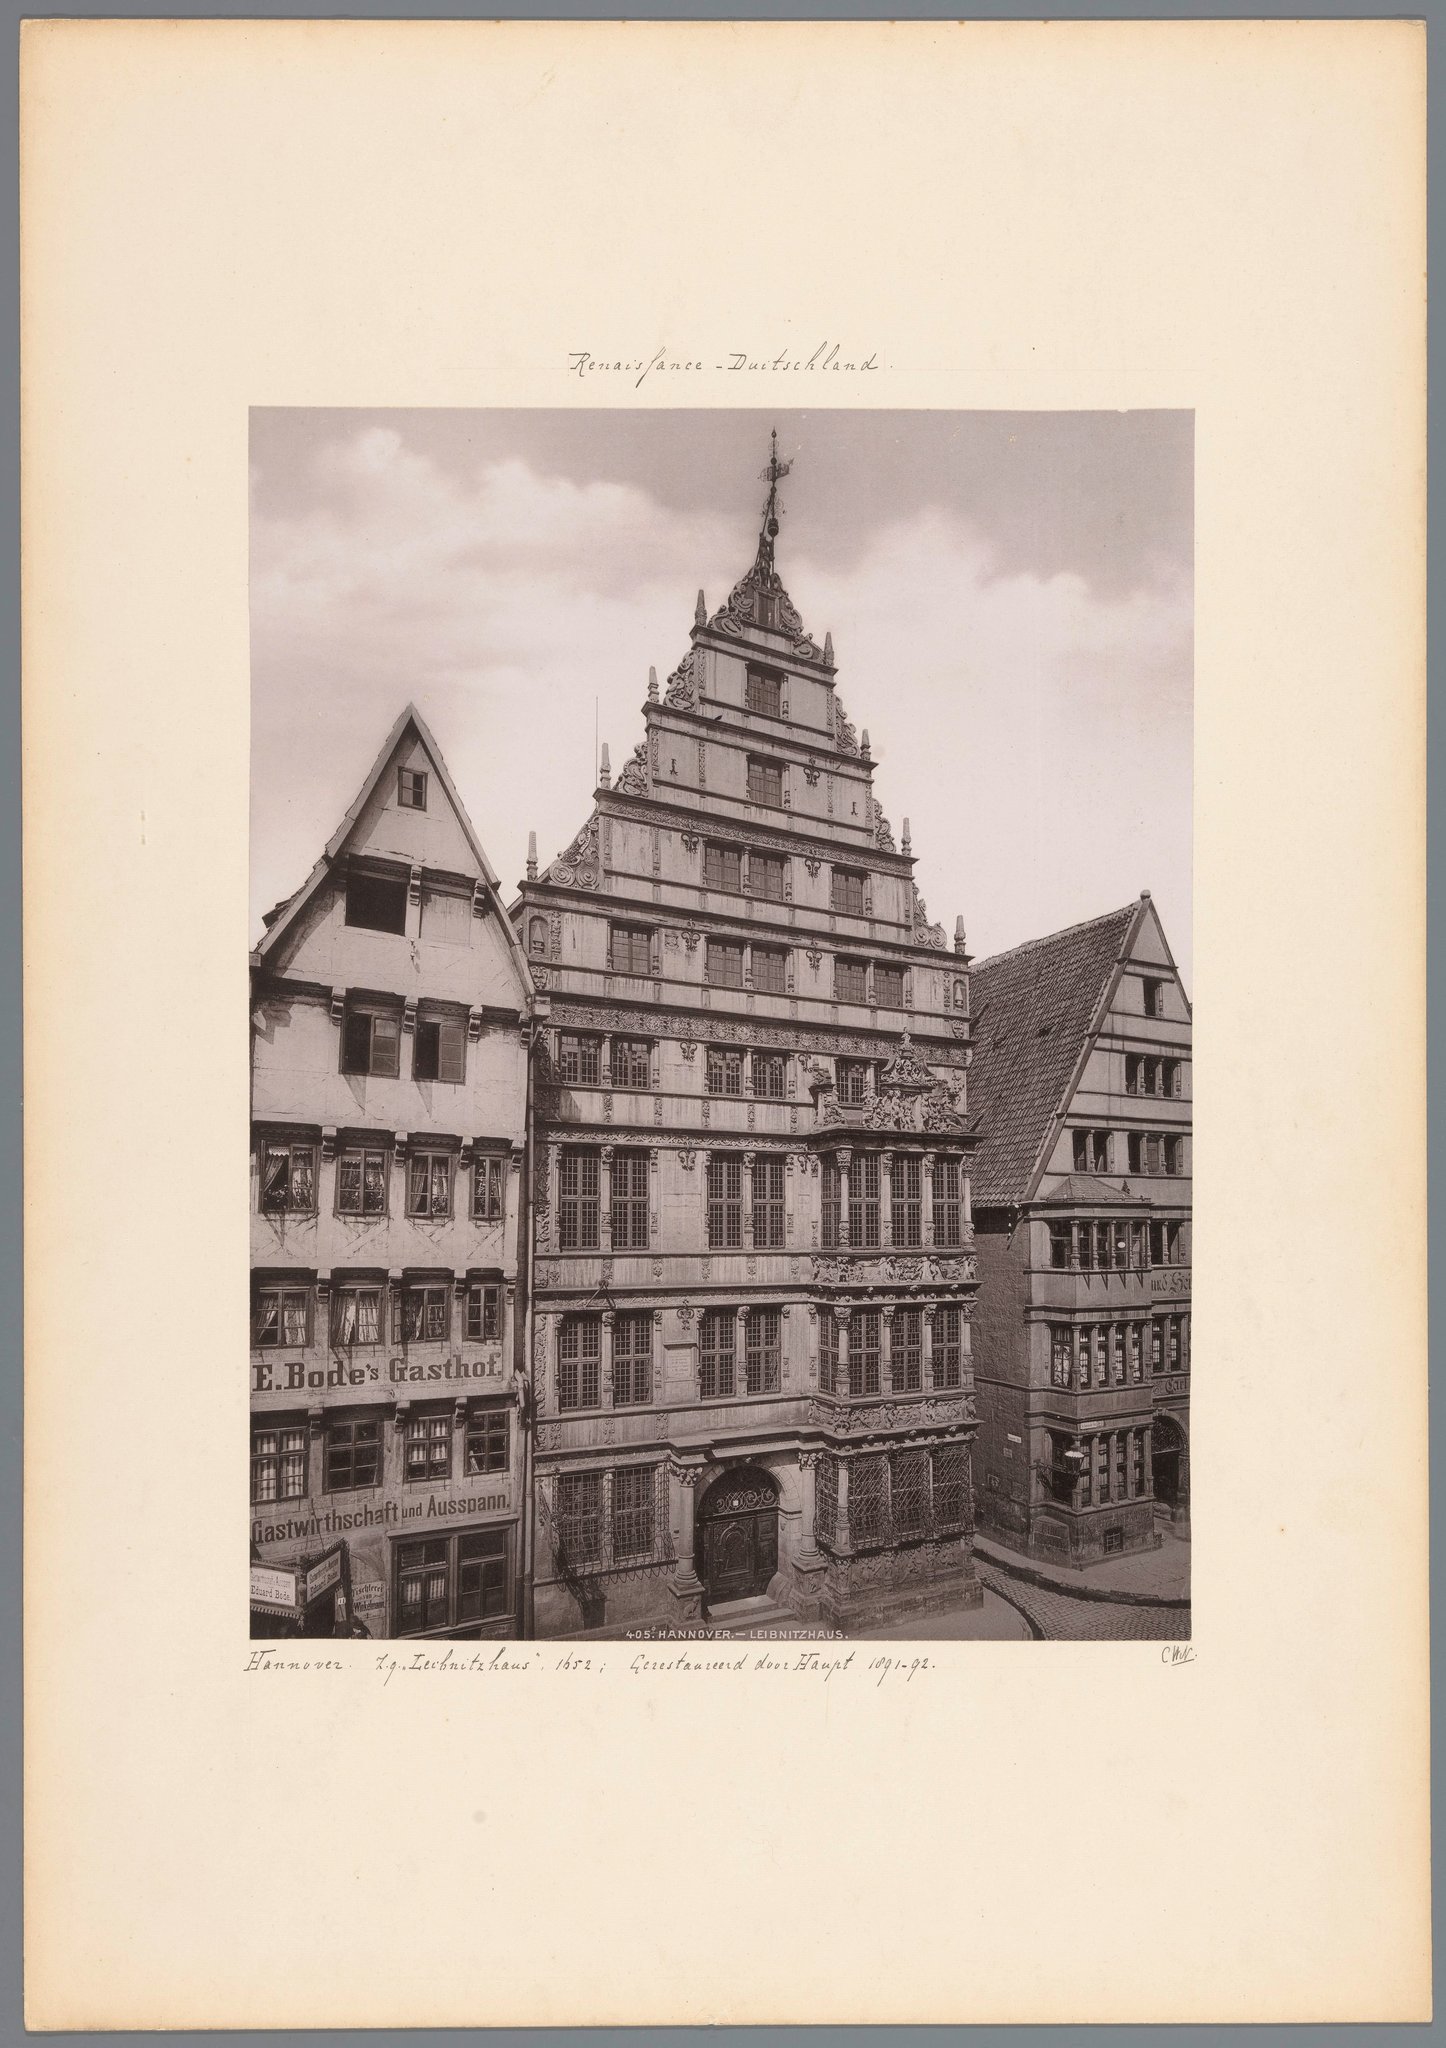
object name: photograph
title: Gezicht van het Leibnizhaus te Hannover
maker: Anonymous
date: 1875-1900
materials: cardboard, paper, ink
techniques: photograph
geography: hannover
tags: urban housing, advertising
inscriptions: number: ‘405.’, inscription: ‘CWN.’, collector's mark: ‘KUNSTNIJVERHEIDSCHOOL QUELLINUS AMSTERDAM FRANS HALSSTRAAT 14.’, inscription: ‘Renaissance - Duitschland.’, collector's mark: ‘INSTITUUT VOOR KUNST-NIJVERHEIDSONDERWIJS GABRIËL METSUSTRAAT No. 16 AMSTERDAM’